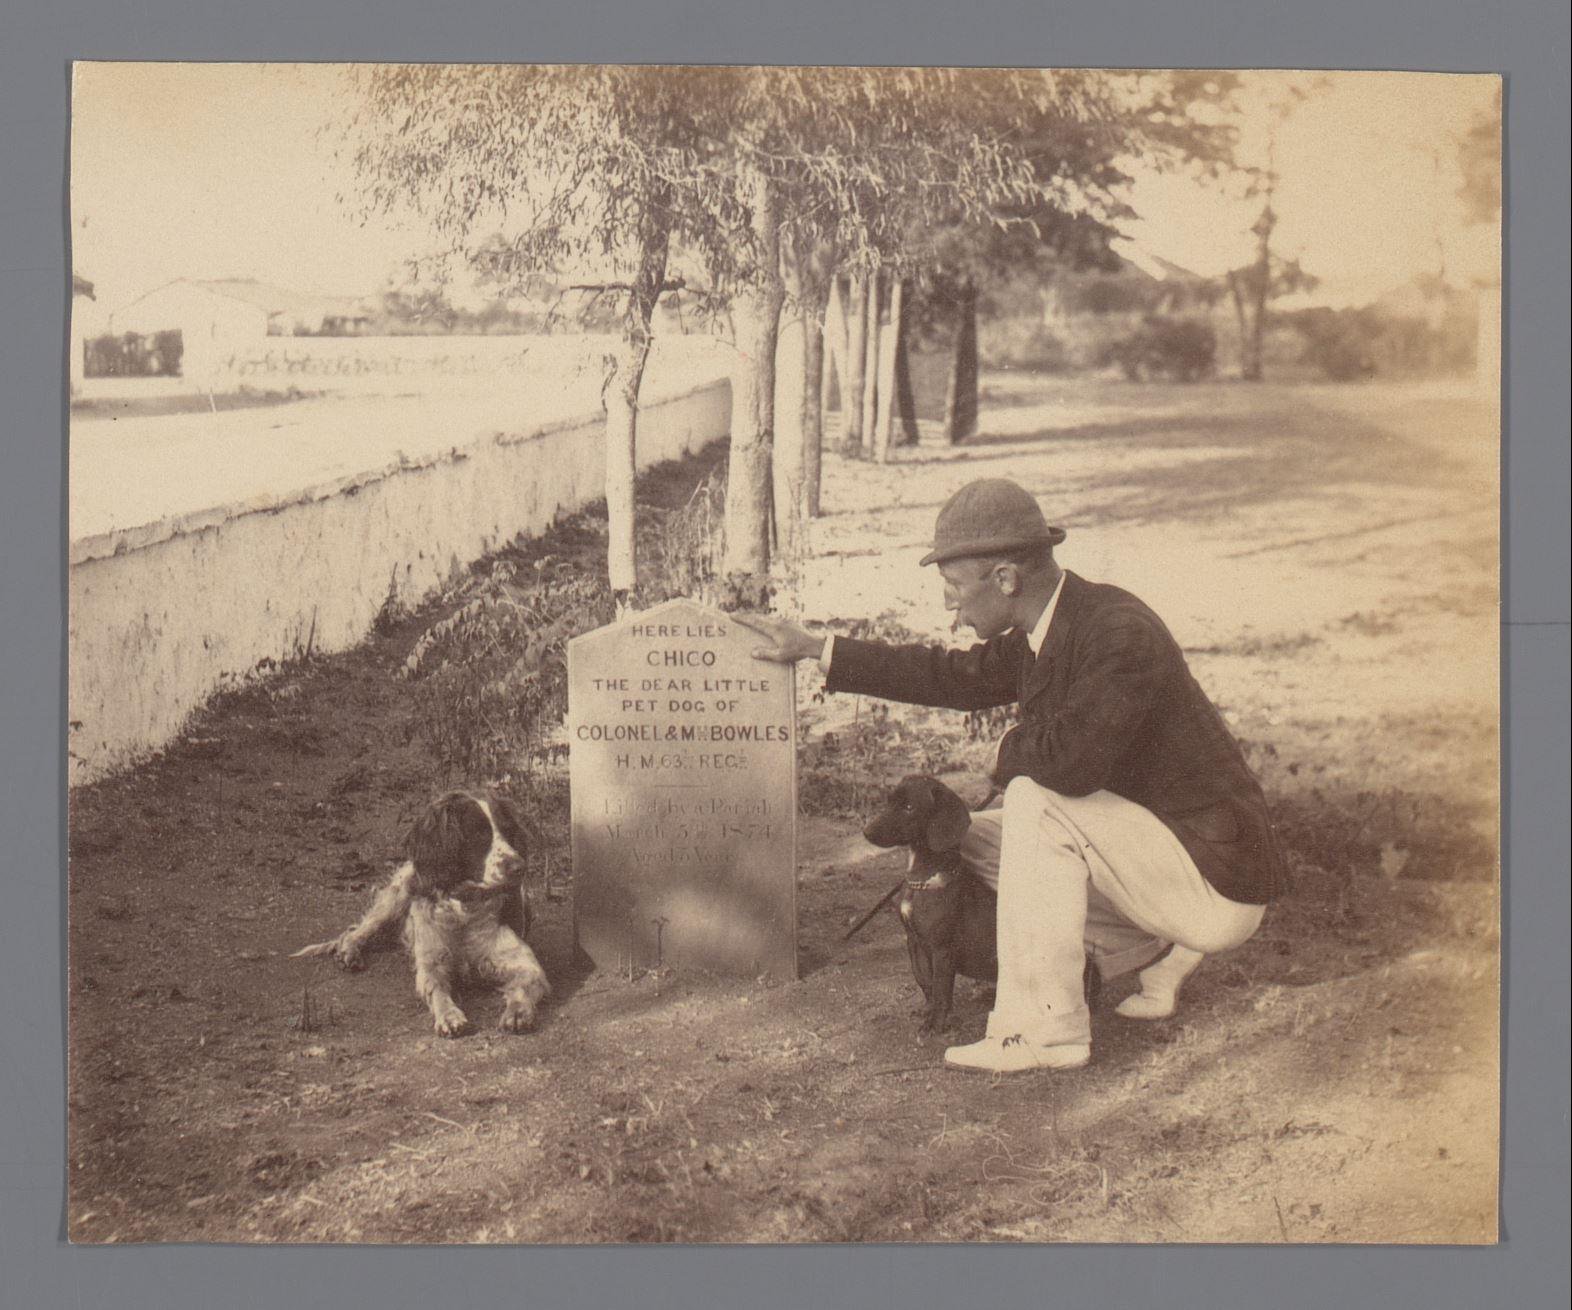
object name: photograph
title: Graf van een hond "Chico", met twee honden en een knielende man ernaast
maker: Anonymous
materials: photographic support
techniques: albumen print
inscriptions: inscription: ‘HERE LIES//CHICO//THE DEAR LITTLE PET DOG OF//COLONEL&MH BOWLES//H.M. 63 REG.//[...?] MARCH 5 1874//AGED 5 [...?]’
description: Graf van een hond "Chico" (gestorven 5 maart 1874) van Colonel &MH Bowles, met twee honden aan weerszijden en een knielende man ernaast.